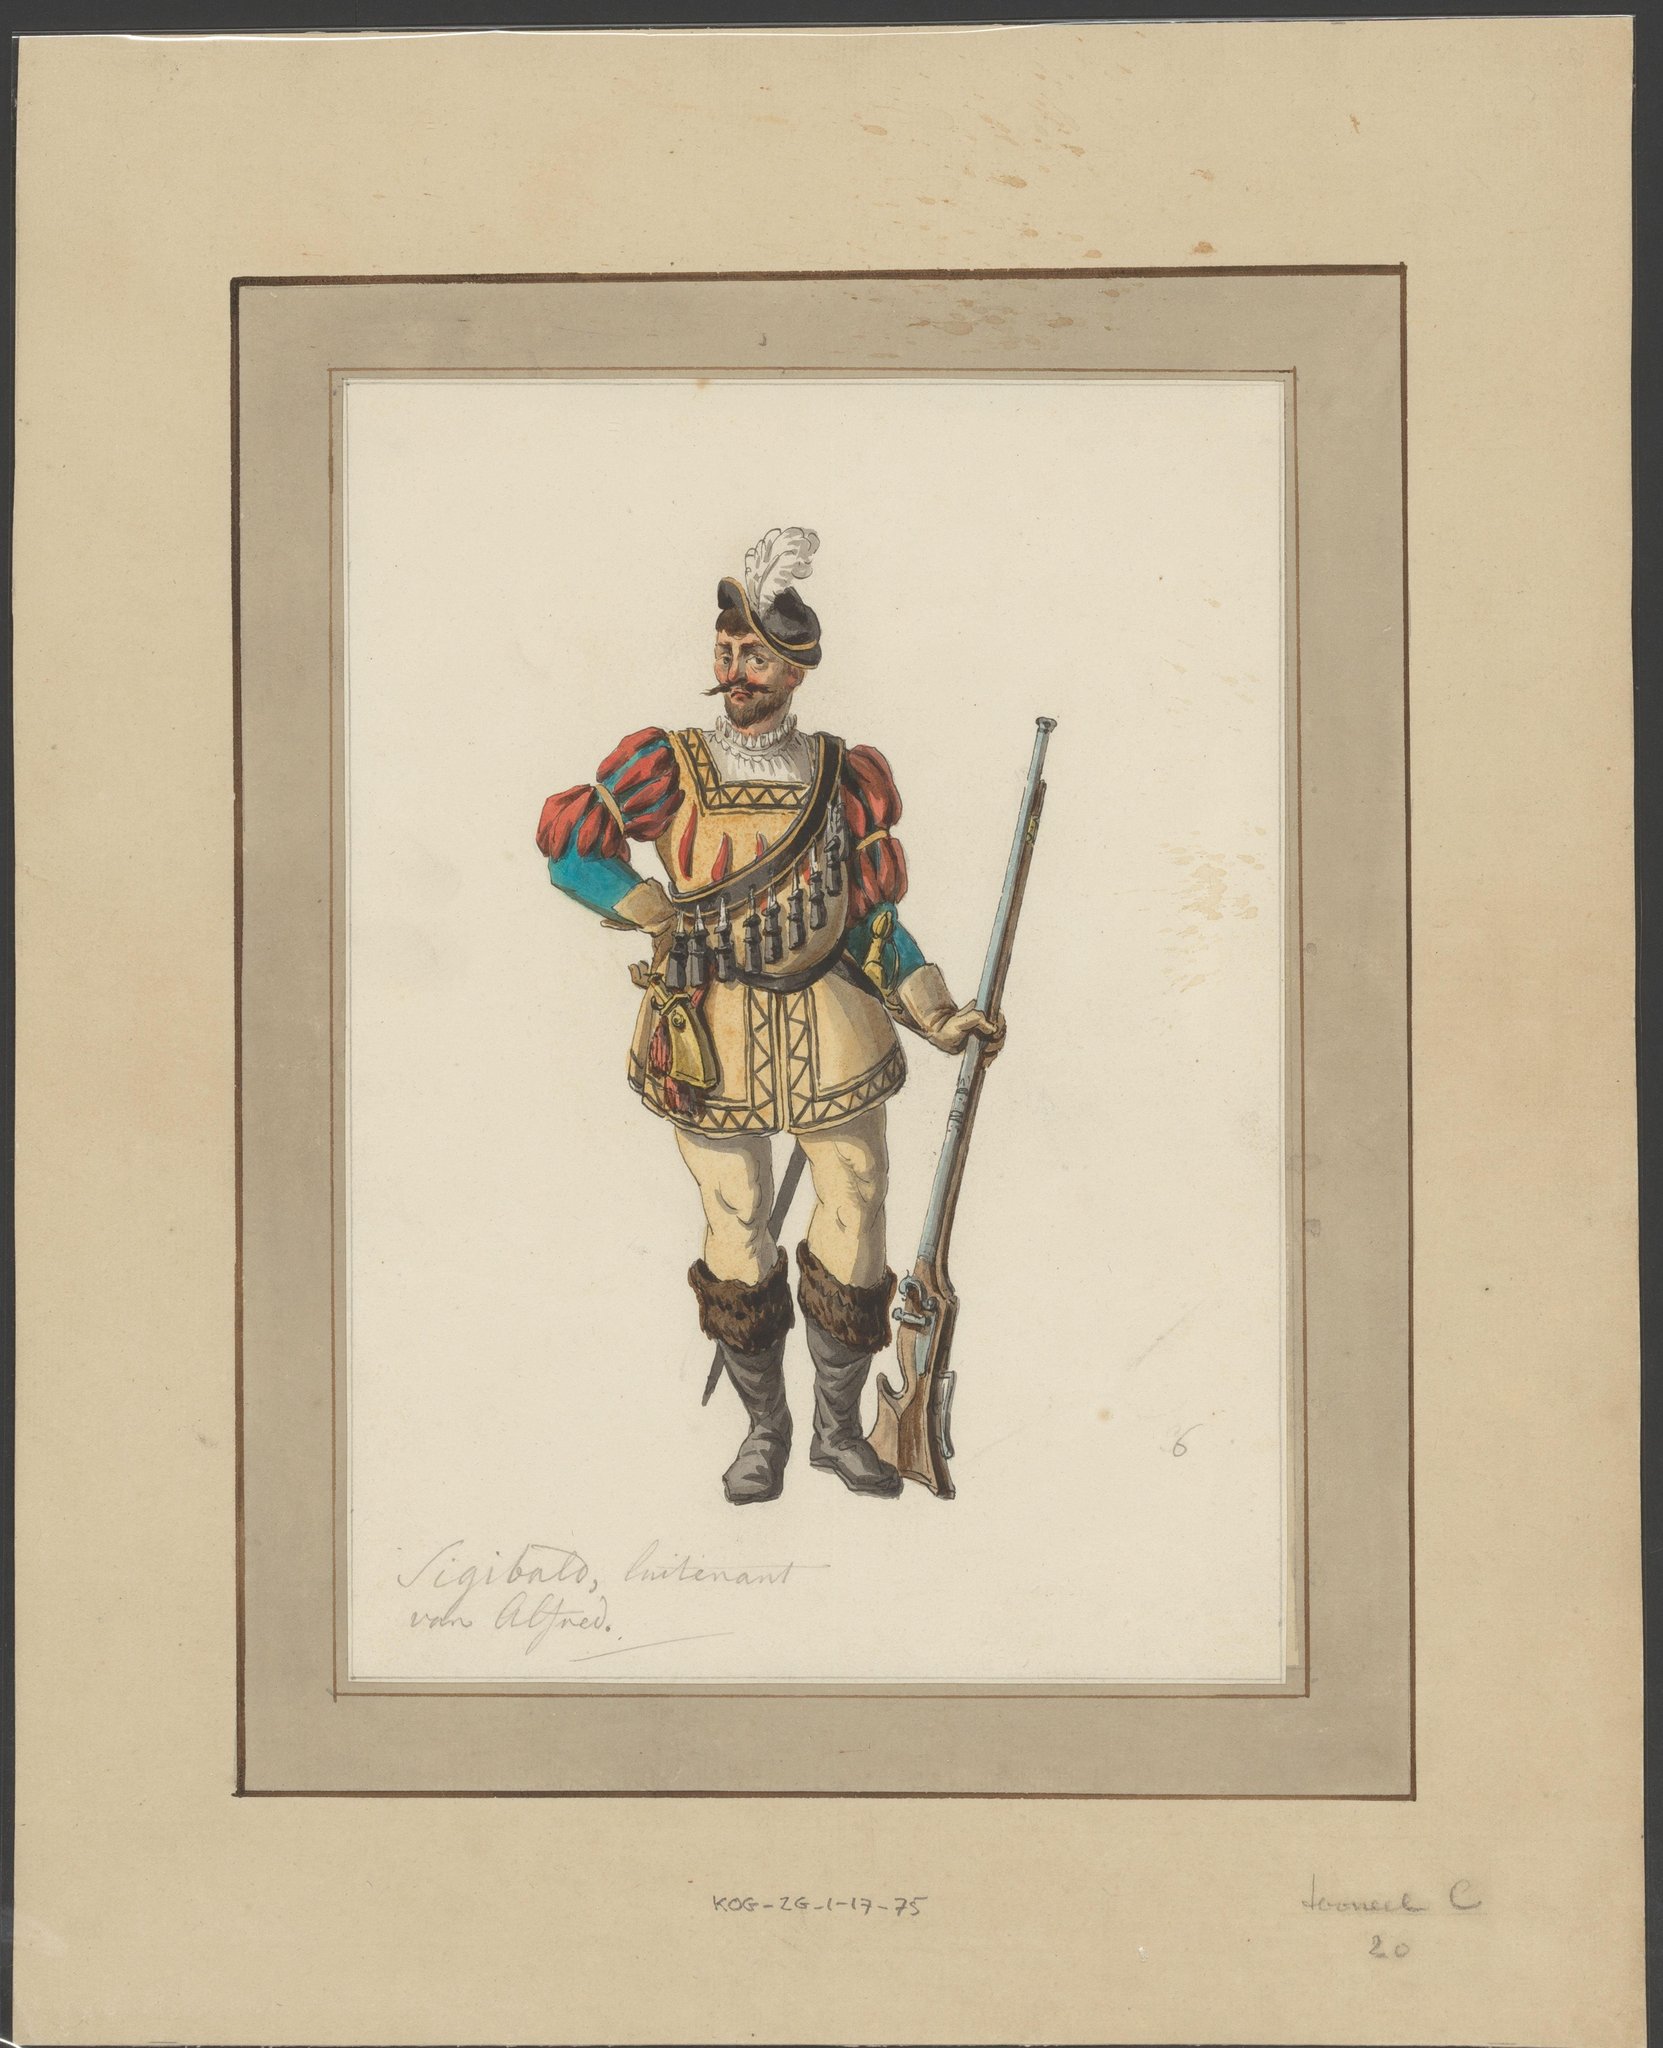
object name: drawing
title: Sigibald, luitenant van Alfred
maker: Anonymous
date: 1800-1825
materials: ink, paper, watercolor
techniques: brush, pen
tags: stage costume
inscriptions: collector's mark: Lugt 1641, stamp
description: Theaterkostuum voor Sigibald een Spaanse krijgsman met geweer. Een karakter uit het toneelstuk: Gustavus of de Zweedsche mijnwerkers van H.J.F. Lamartêliere. Onderwerpsrubrieken binnen de Atlas Zeden en Gewoonten: Tooneel, Ontwerpen costumes.